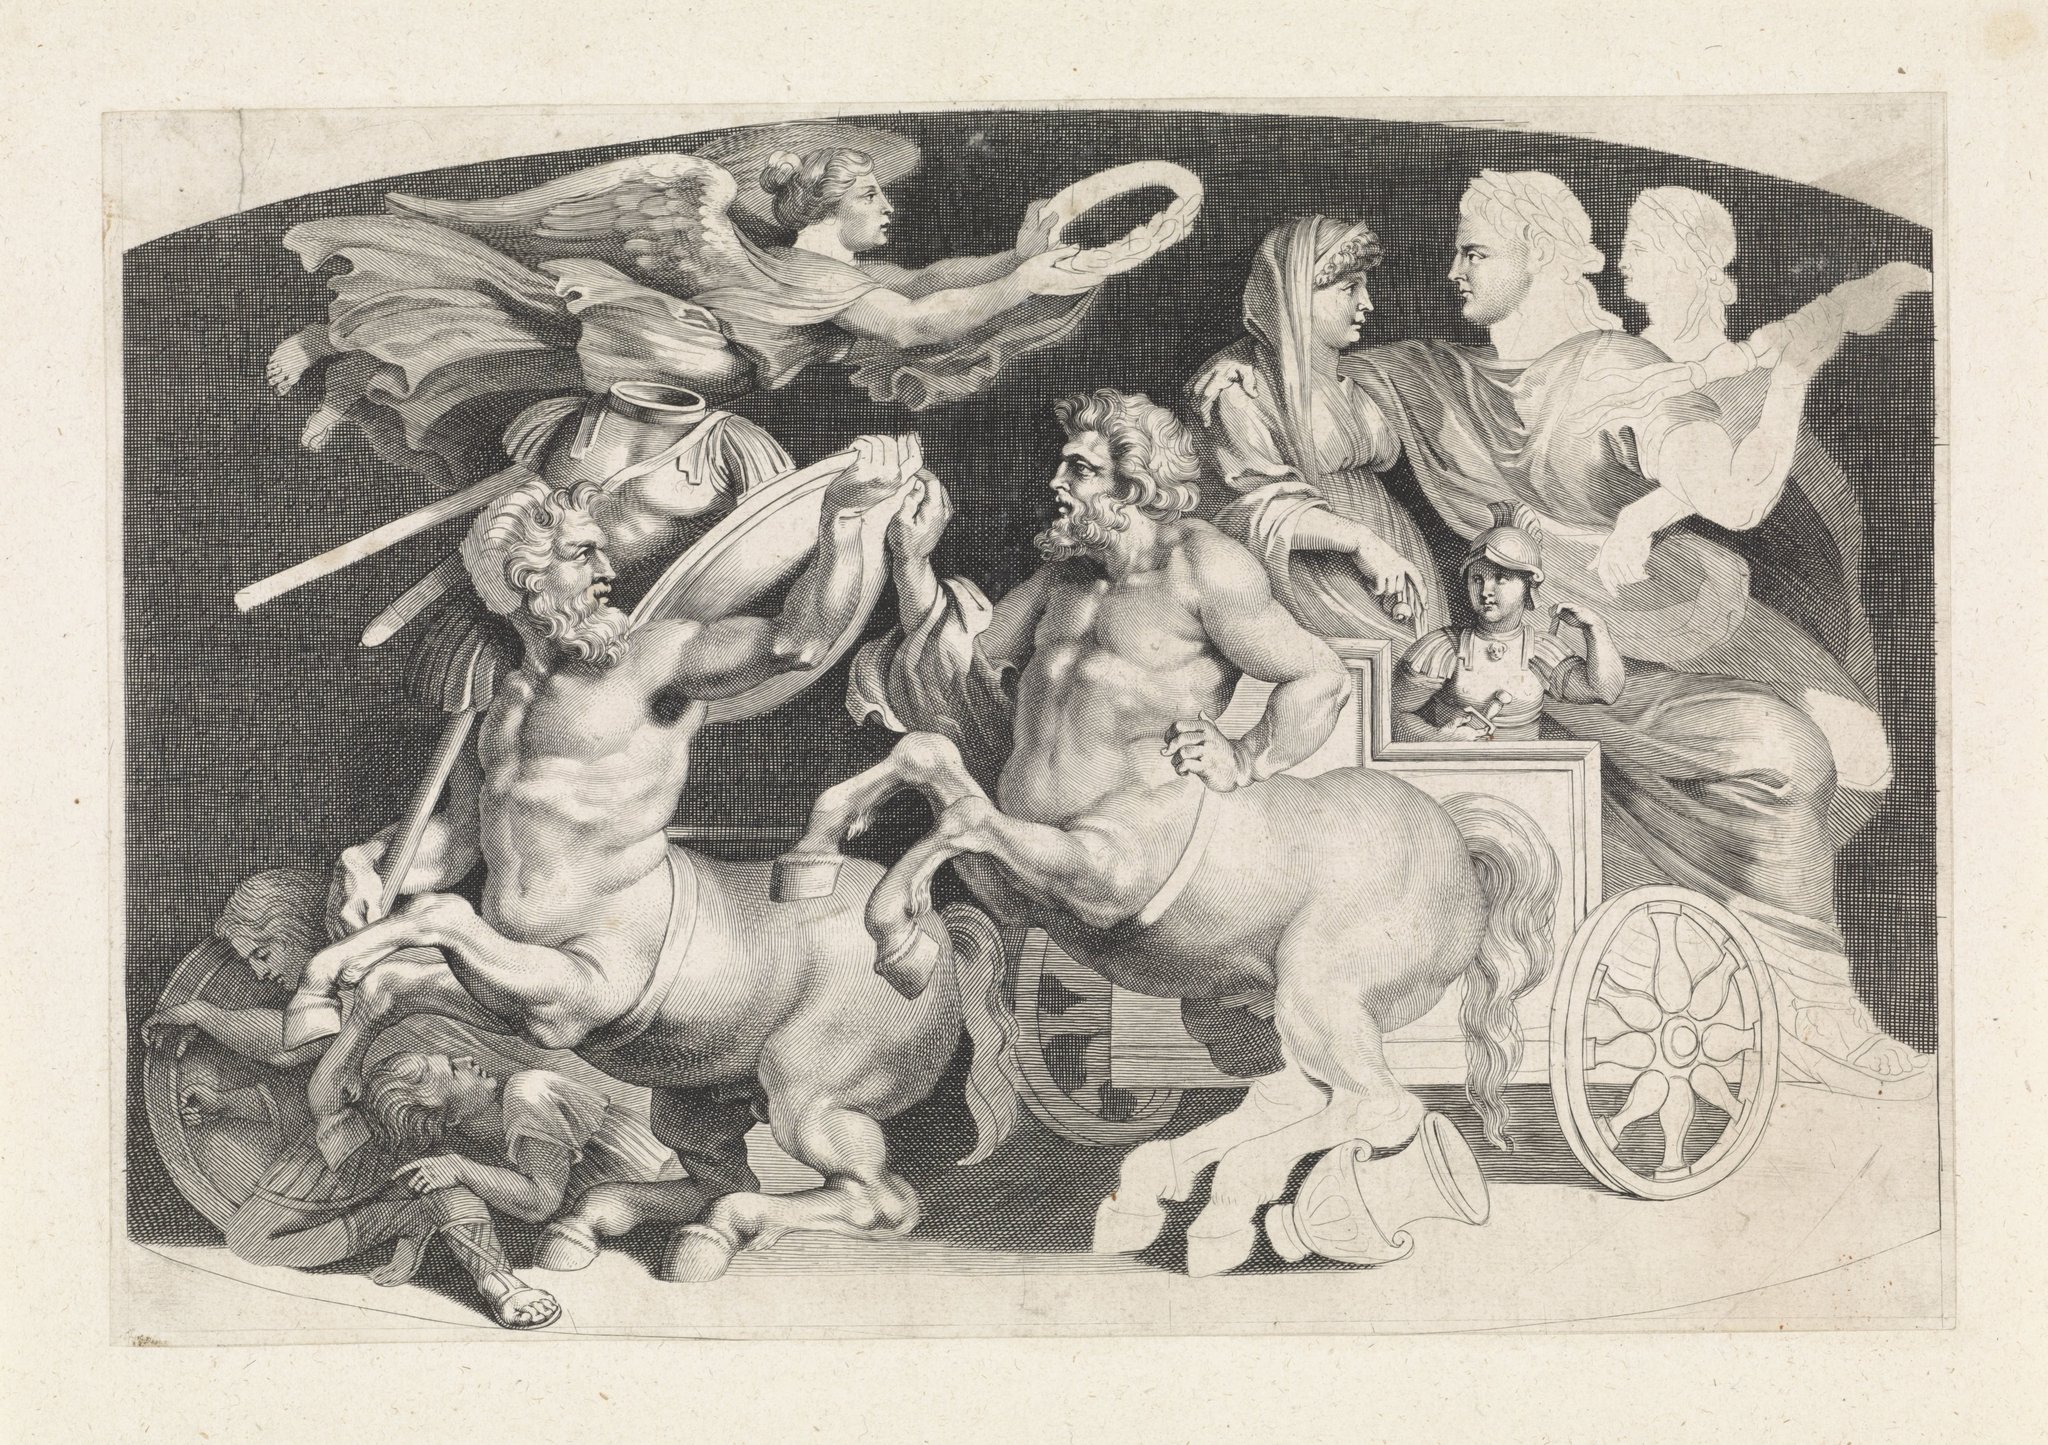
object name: print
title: Camee met de triomf van Germanicus en Agrippina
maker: paulus pontius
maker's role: draughtsman, print maker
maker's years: 1603-1658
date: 1616-1657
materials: paper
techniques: engraving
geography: antwerp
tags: (story of) germanicus (+ ideal or heroic representation), lapidary, brooch, agraffe, clasp, precious and semiprecious stones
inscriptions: collector's mark: Lugt 240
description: Een camee met een voorstelling van de triomf van Germanicus en Agrippina (of de triomf van Constantijn). Een Romeinse veldheer met zijn echtgenote in een triomfwagen getrokken door twee centauren. Onvoltooide voorstelling. De camee werd geveild in de Munt van Amsterdam op 11 september 1765.